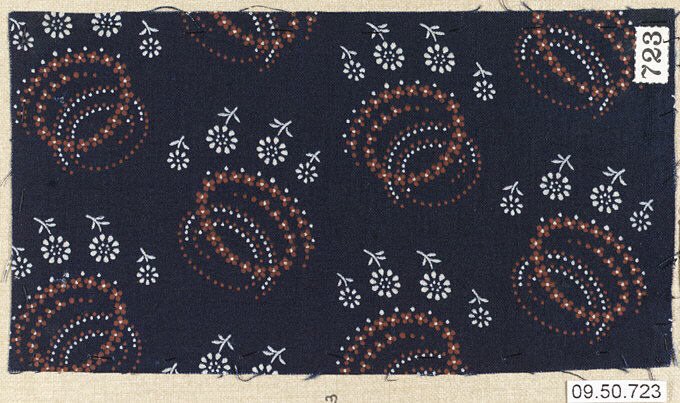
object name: piece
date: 1801-1900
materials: cotton